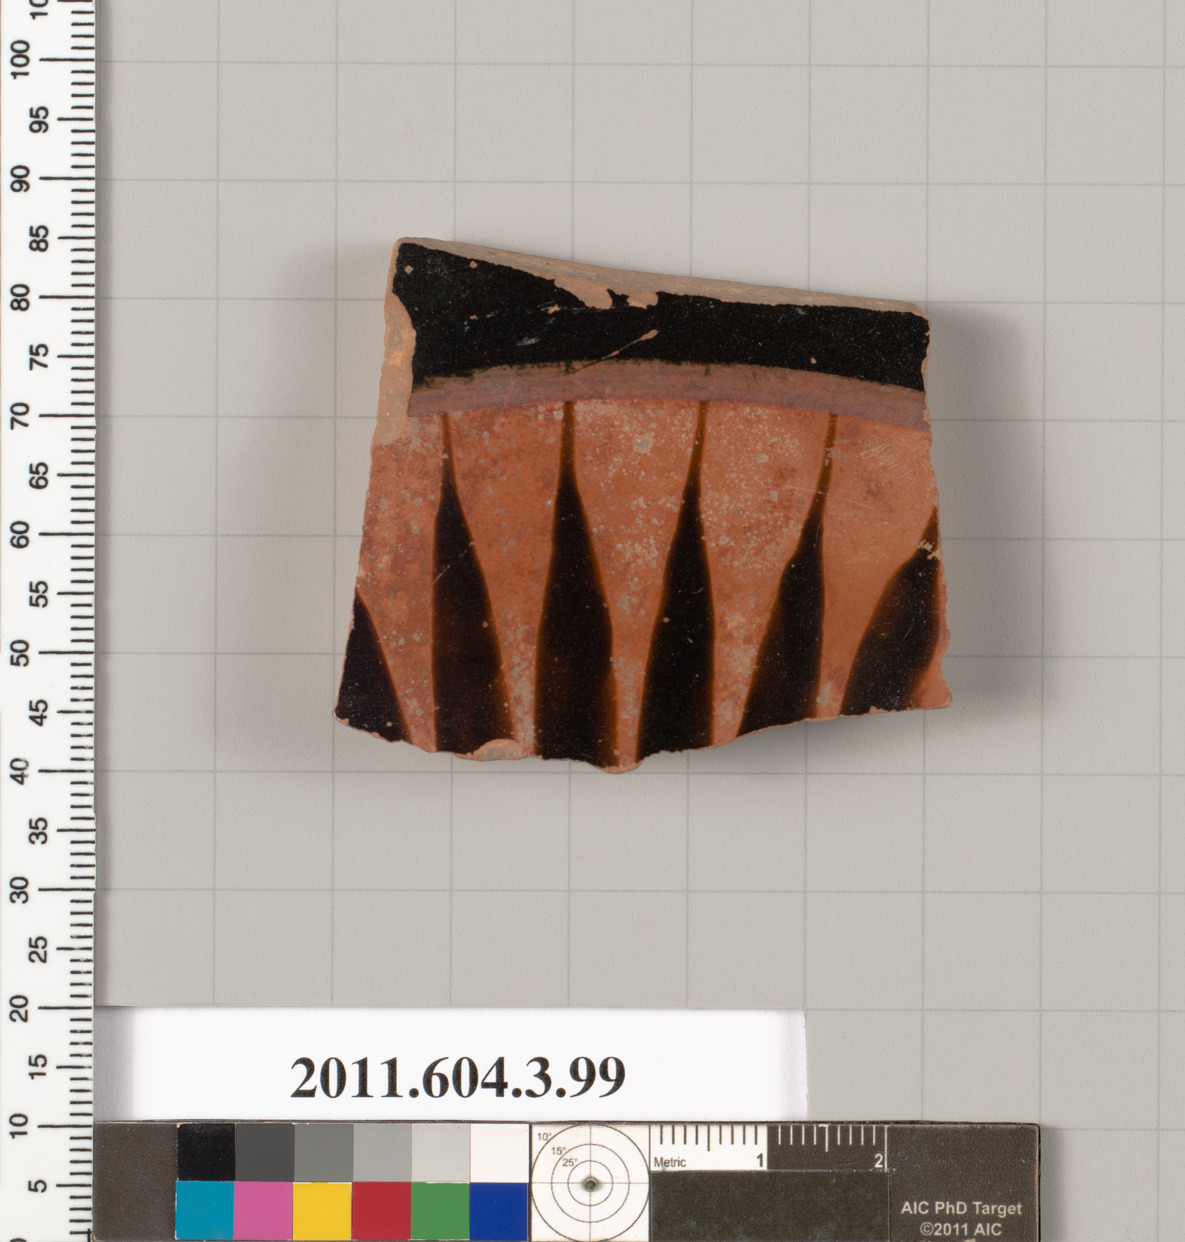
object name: amphora fragment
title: Terracotta fragment of an amphora (jar)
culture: greek, attic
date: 600-468 BCE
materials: terracotta